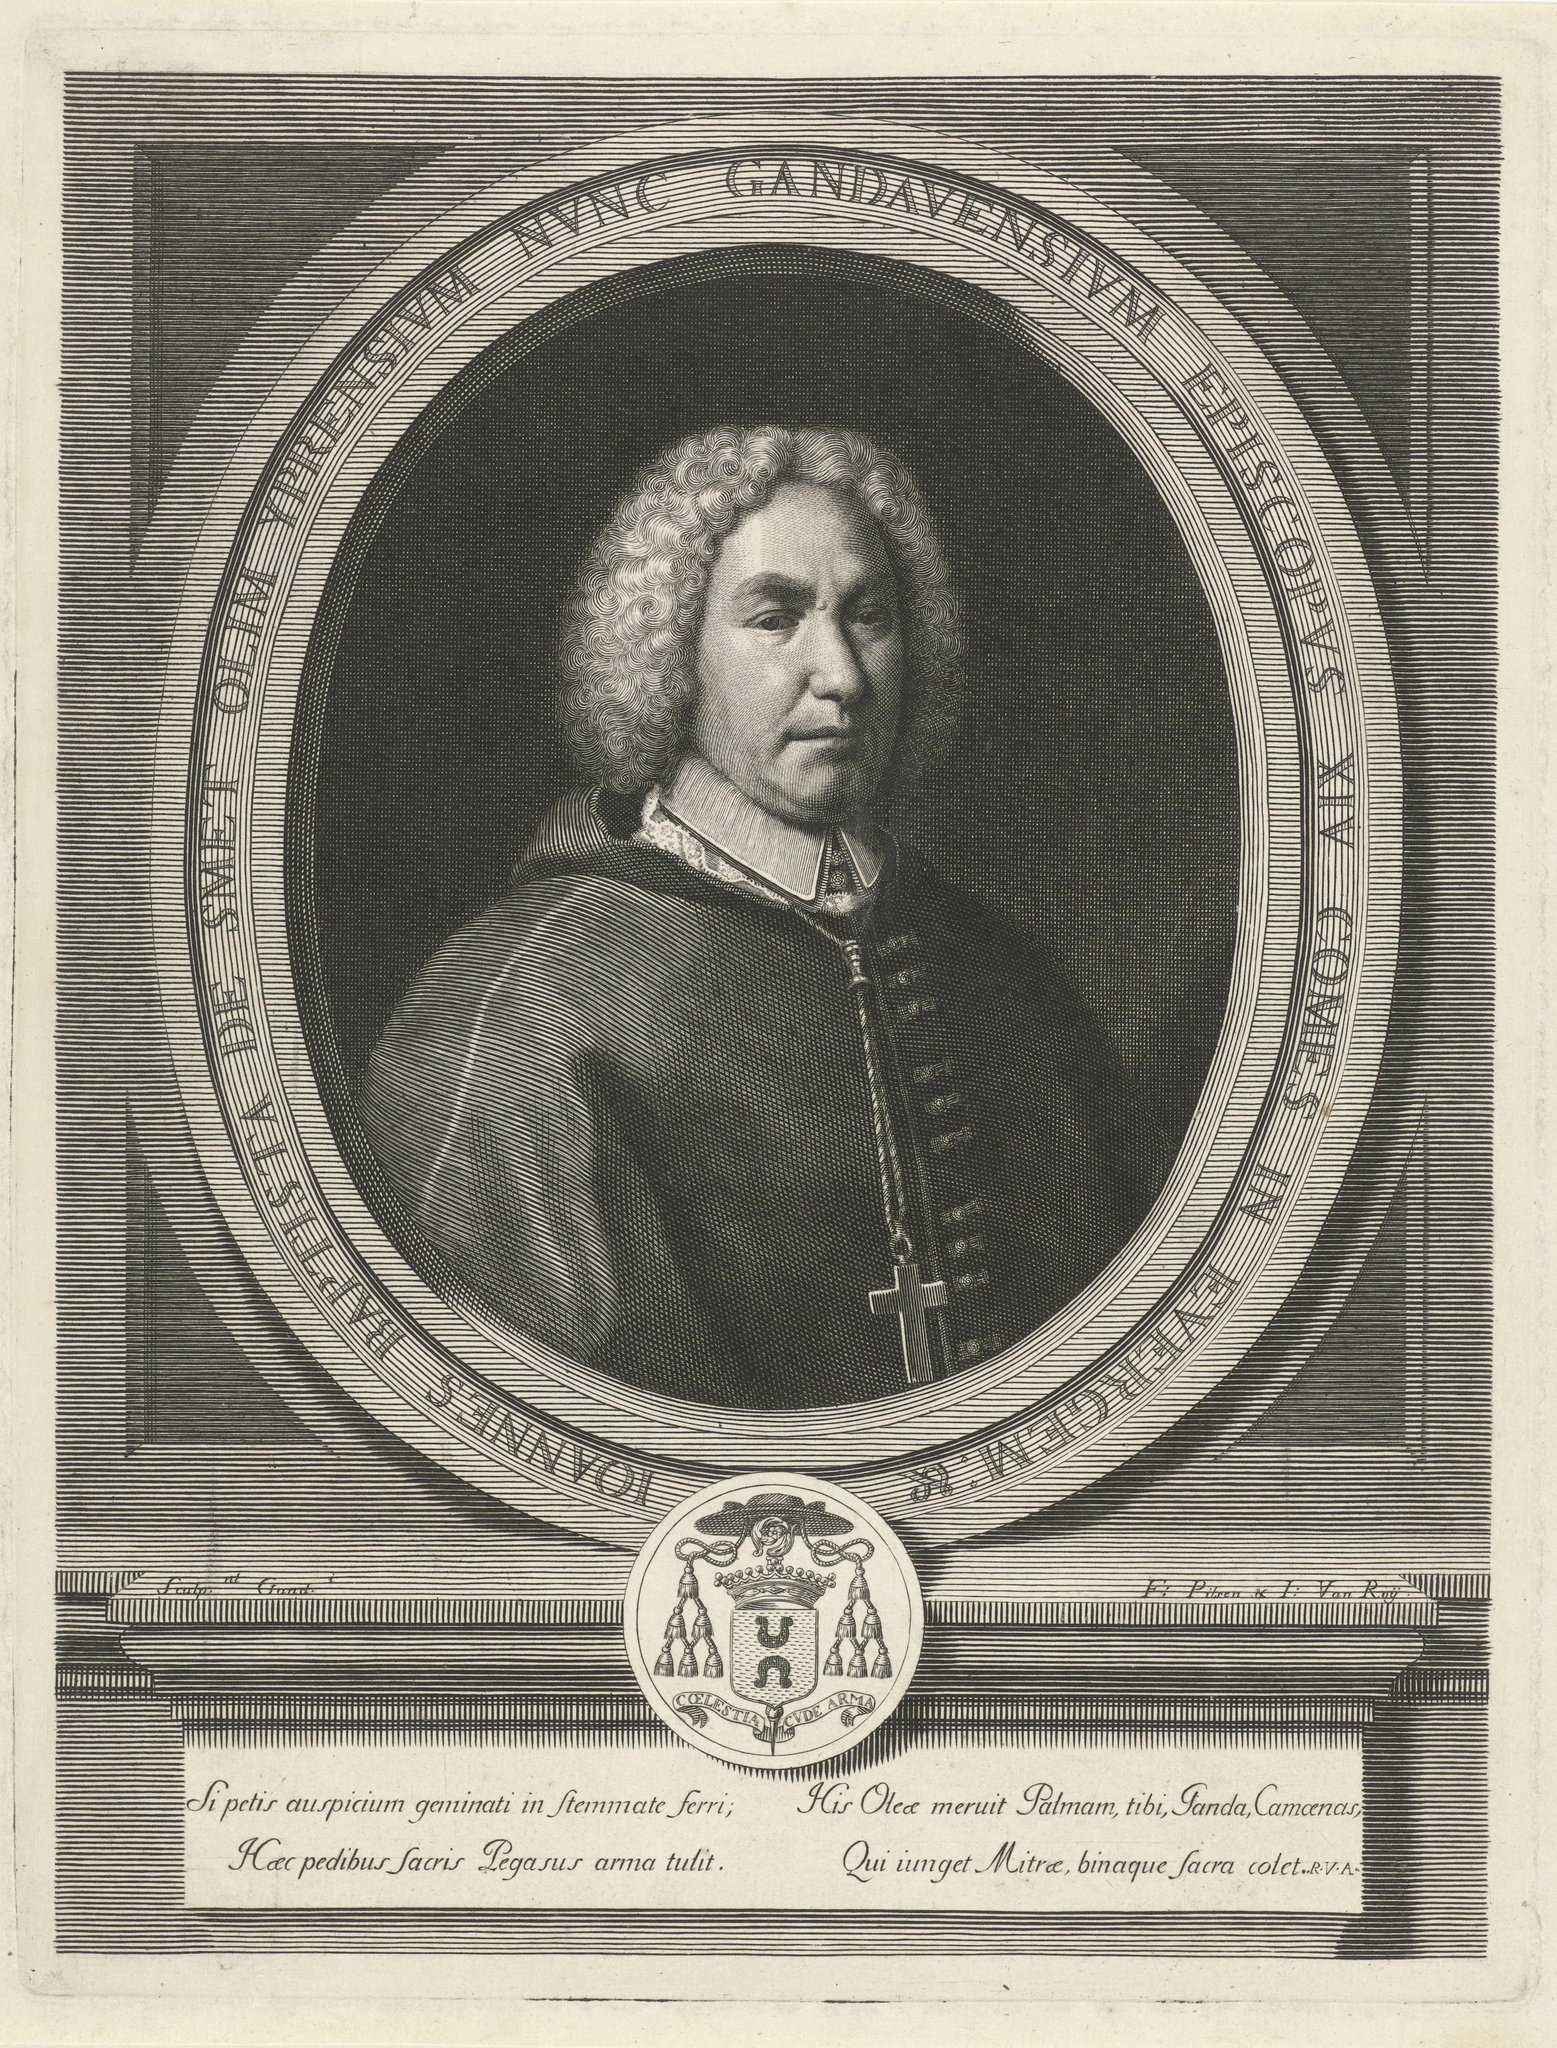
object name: print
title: Portret van Jan Baptist de Smet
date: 1710-1784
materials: paper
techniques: engraving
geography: ghent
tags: ghent, jan-baptist de smet, archbishop, bishop, etc. (roman catholic)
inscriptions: collector's mark: Lugt 2228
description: Portret van Jan Baptist de Smet, bisschop van Gent. Op de piëdestal zijn wapenschild met zijn devies in het Latijn.